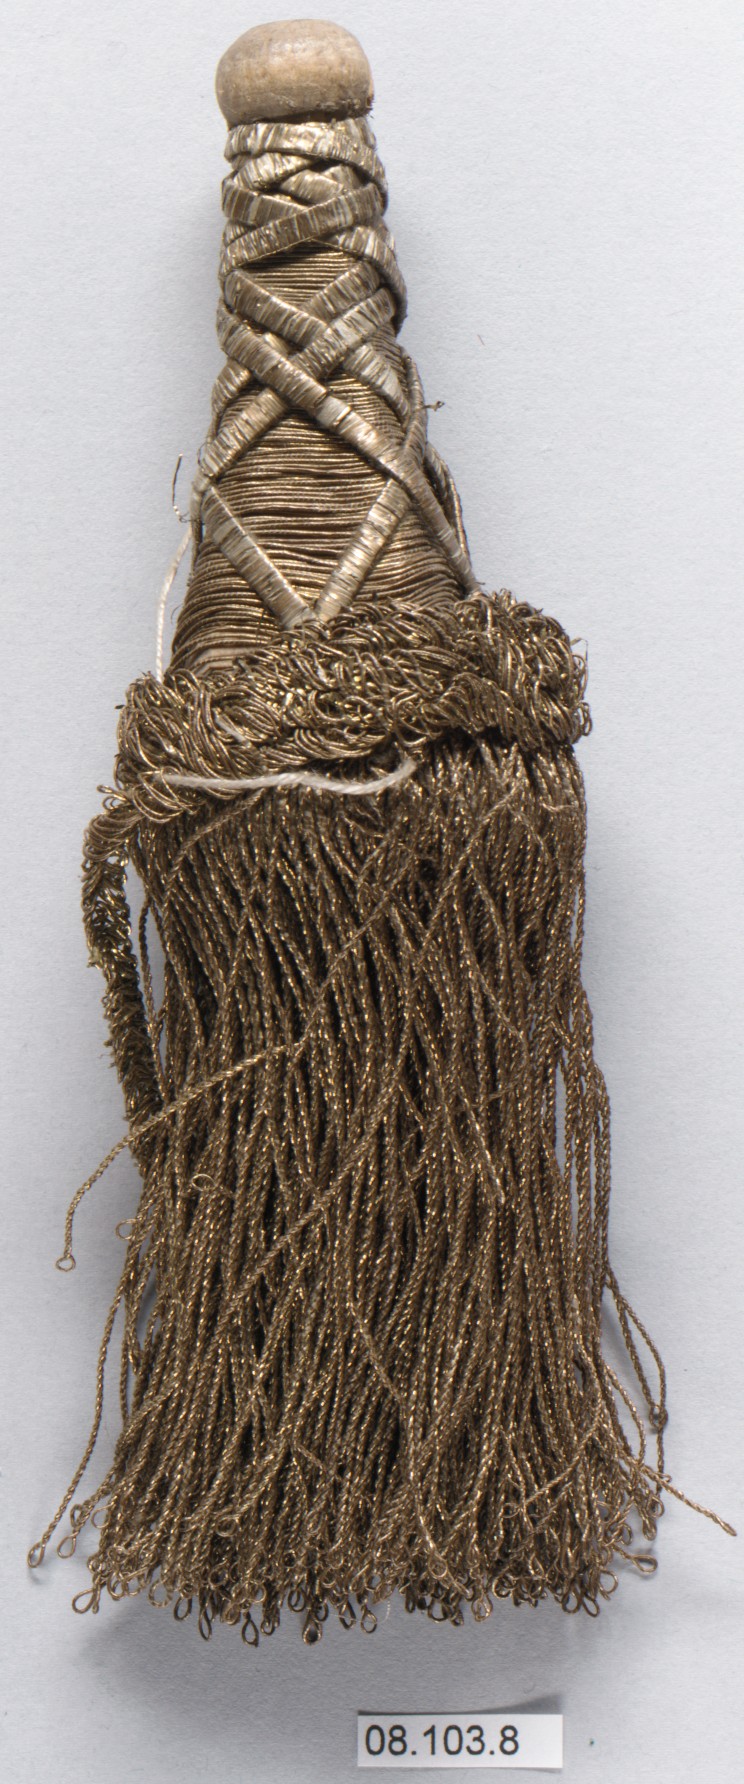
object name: tassel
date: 1701-1800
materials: metal thread